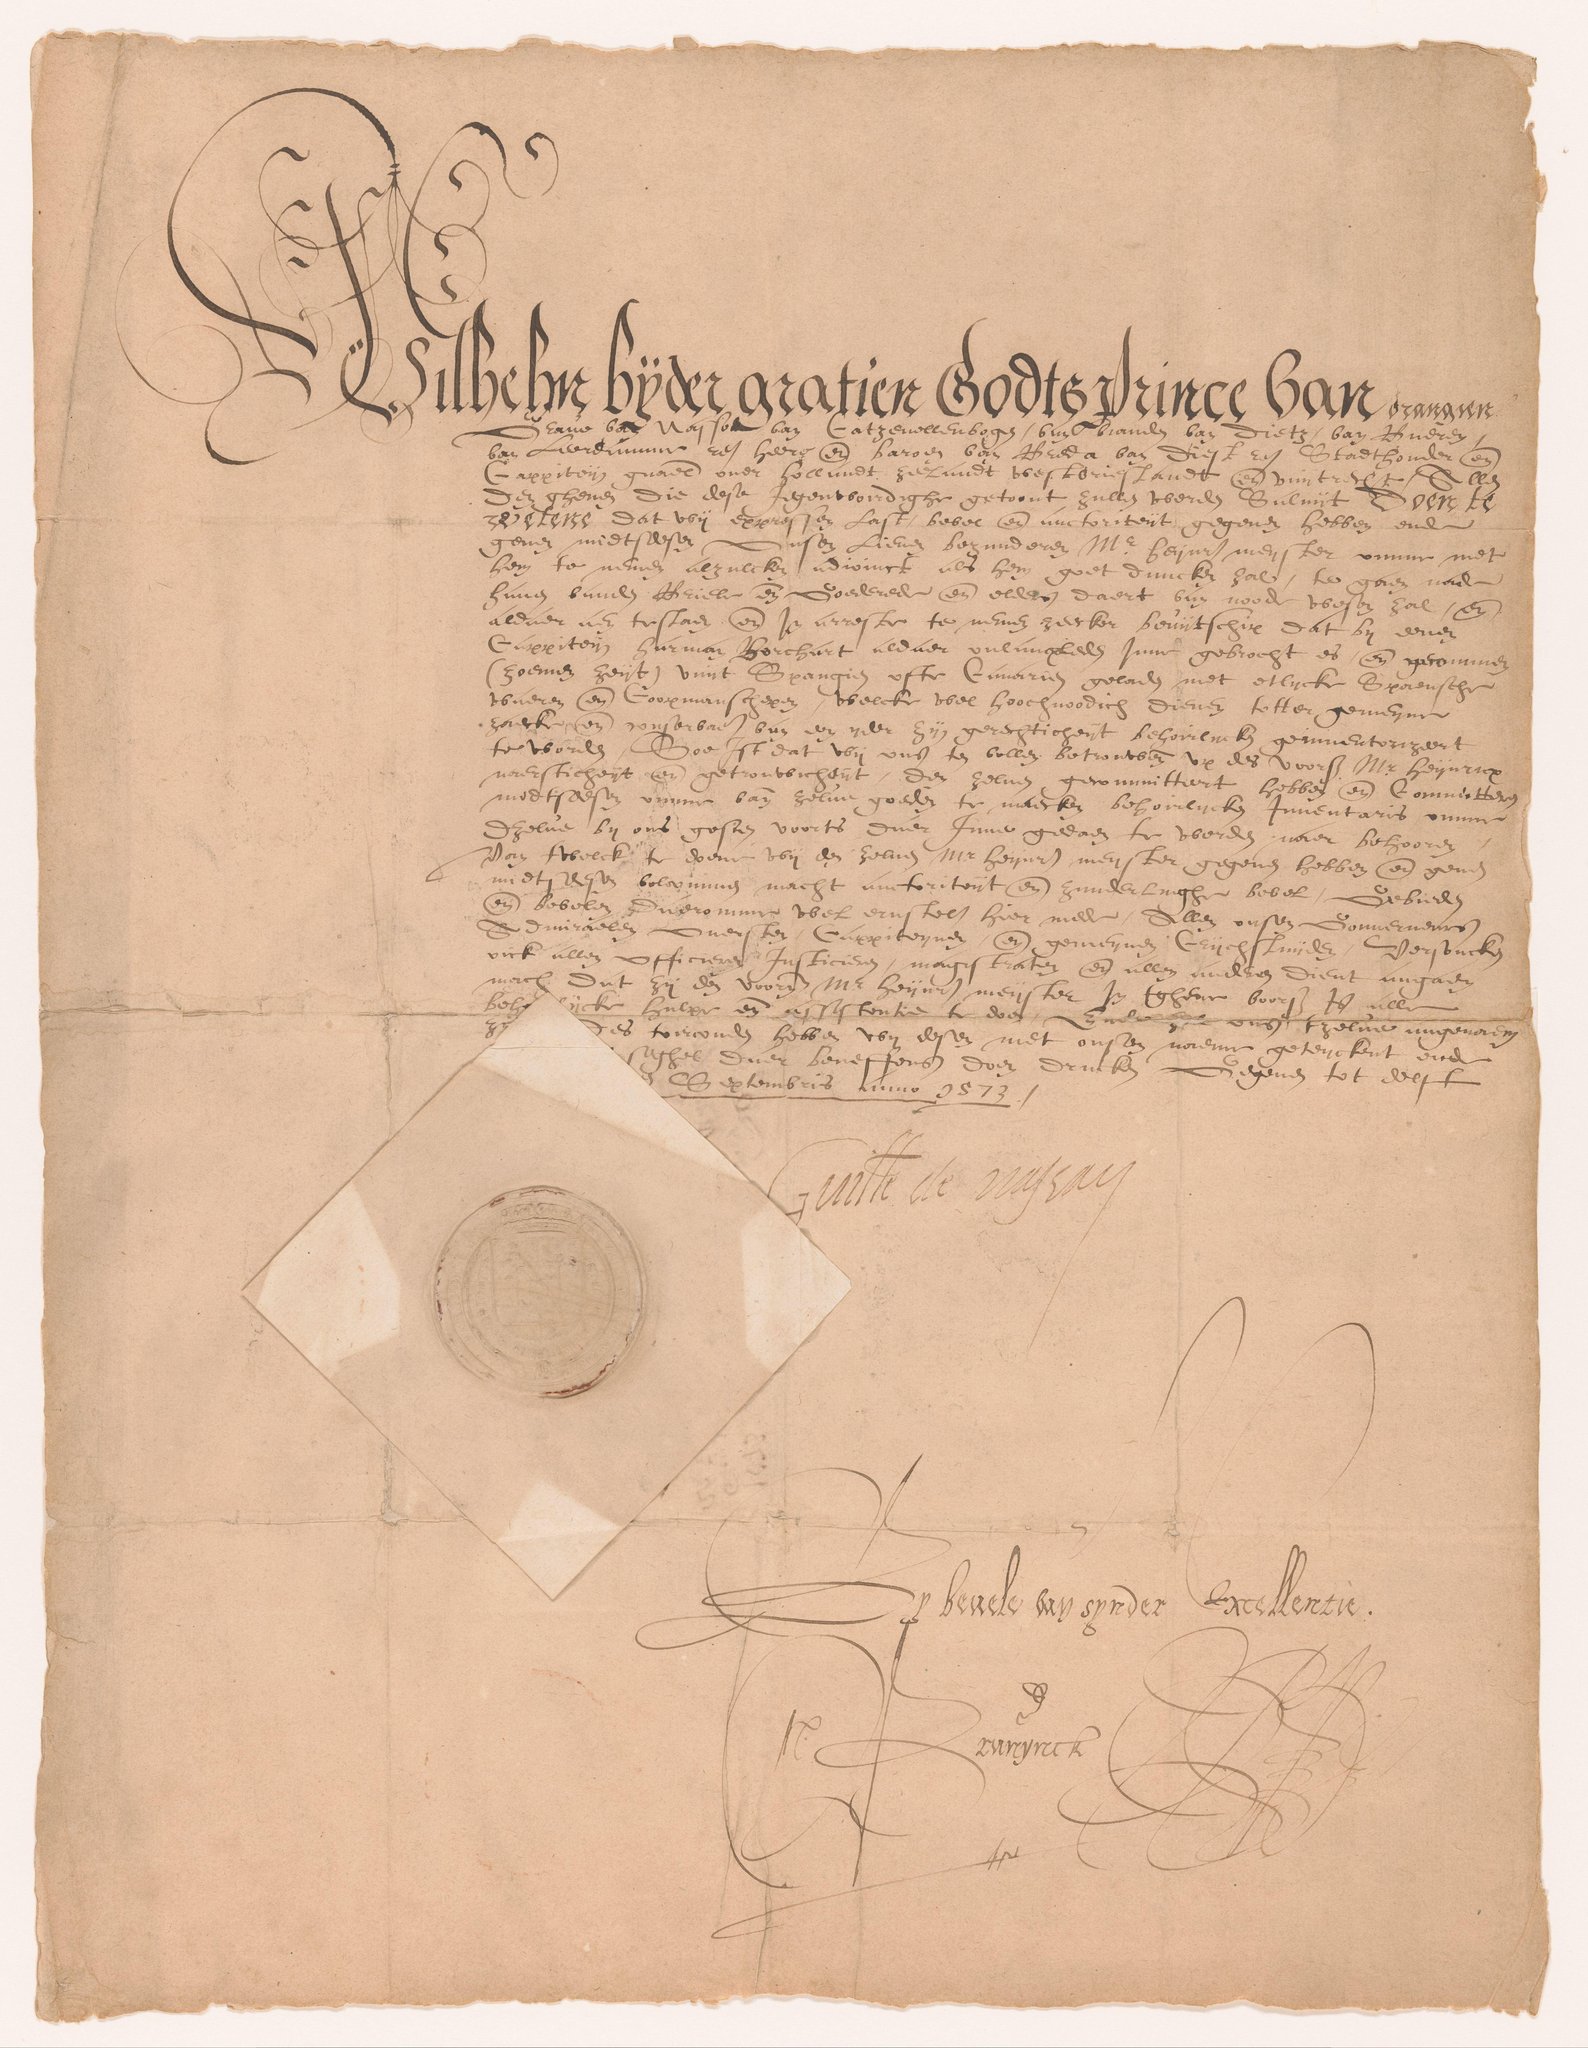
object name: letter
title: Brief van Willem de Zwijger aan Mr Heijnrick Meijster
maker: william i (prince of orange)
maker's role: stadhouder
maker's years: 1533-1584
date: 1573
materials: ink, paper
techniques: writing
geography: delft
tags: delft, william i (prince of orange), netherlands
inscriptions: date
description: Handgeschreven brief met 2 ondertekeningen (van Willem de Zwijger en zijn secretaris N. Brunynck). De brief is eenzijdig beschreven door N. Bruyninck en voorzien van zegel met gekroond wapen. Korte tekst op de achterzijde: 1573 de 28 sbr Comissie van zijnen Exc. op Mr. Henrick Meyster omme een schip te inventariseren. Opschrift: Wilhelm bij den gratiën Godts Prince van Orangien ... by bevele van synder excellentie. Gemerkt: zegel met gekroond wapen. Gedateerd: XXVIIIen septembris anno 1573. Gesigneerd.